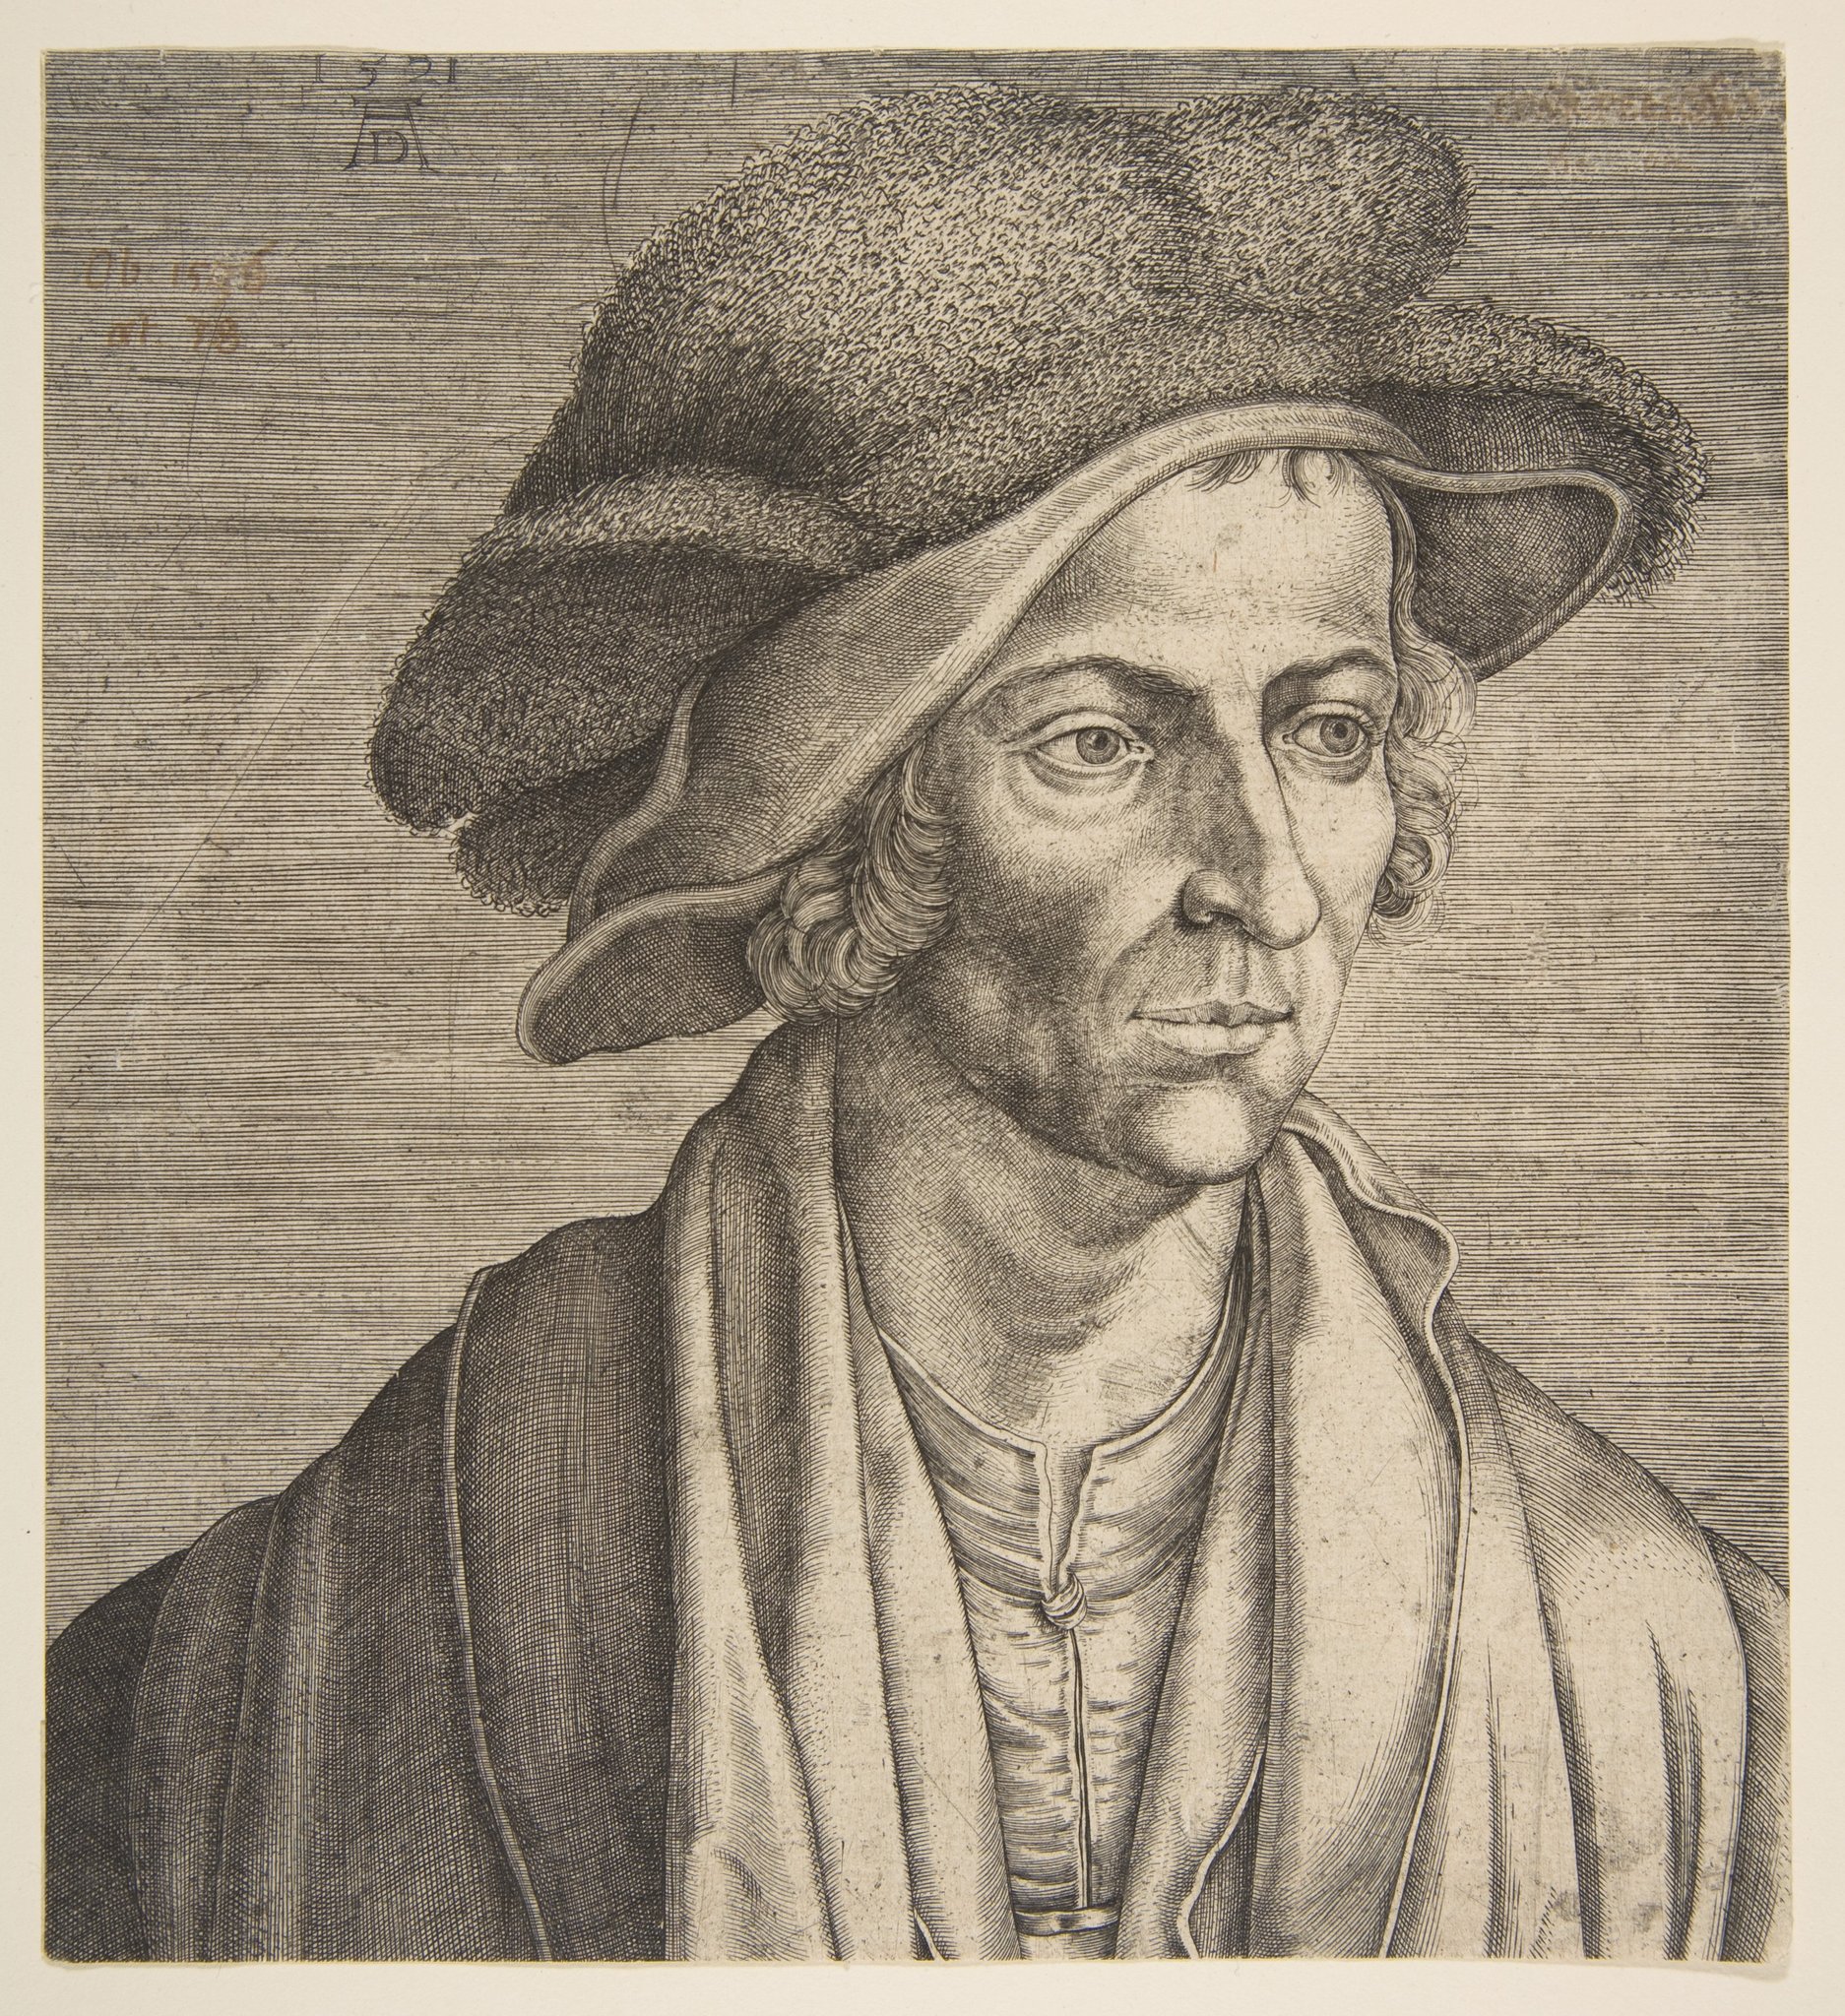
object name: print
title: Joachim Patinir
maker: aegidius sadeler (ii)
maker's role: artist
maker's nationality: flemish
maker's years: 1568-1629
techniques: engraving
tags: men,portraits